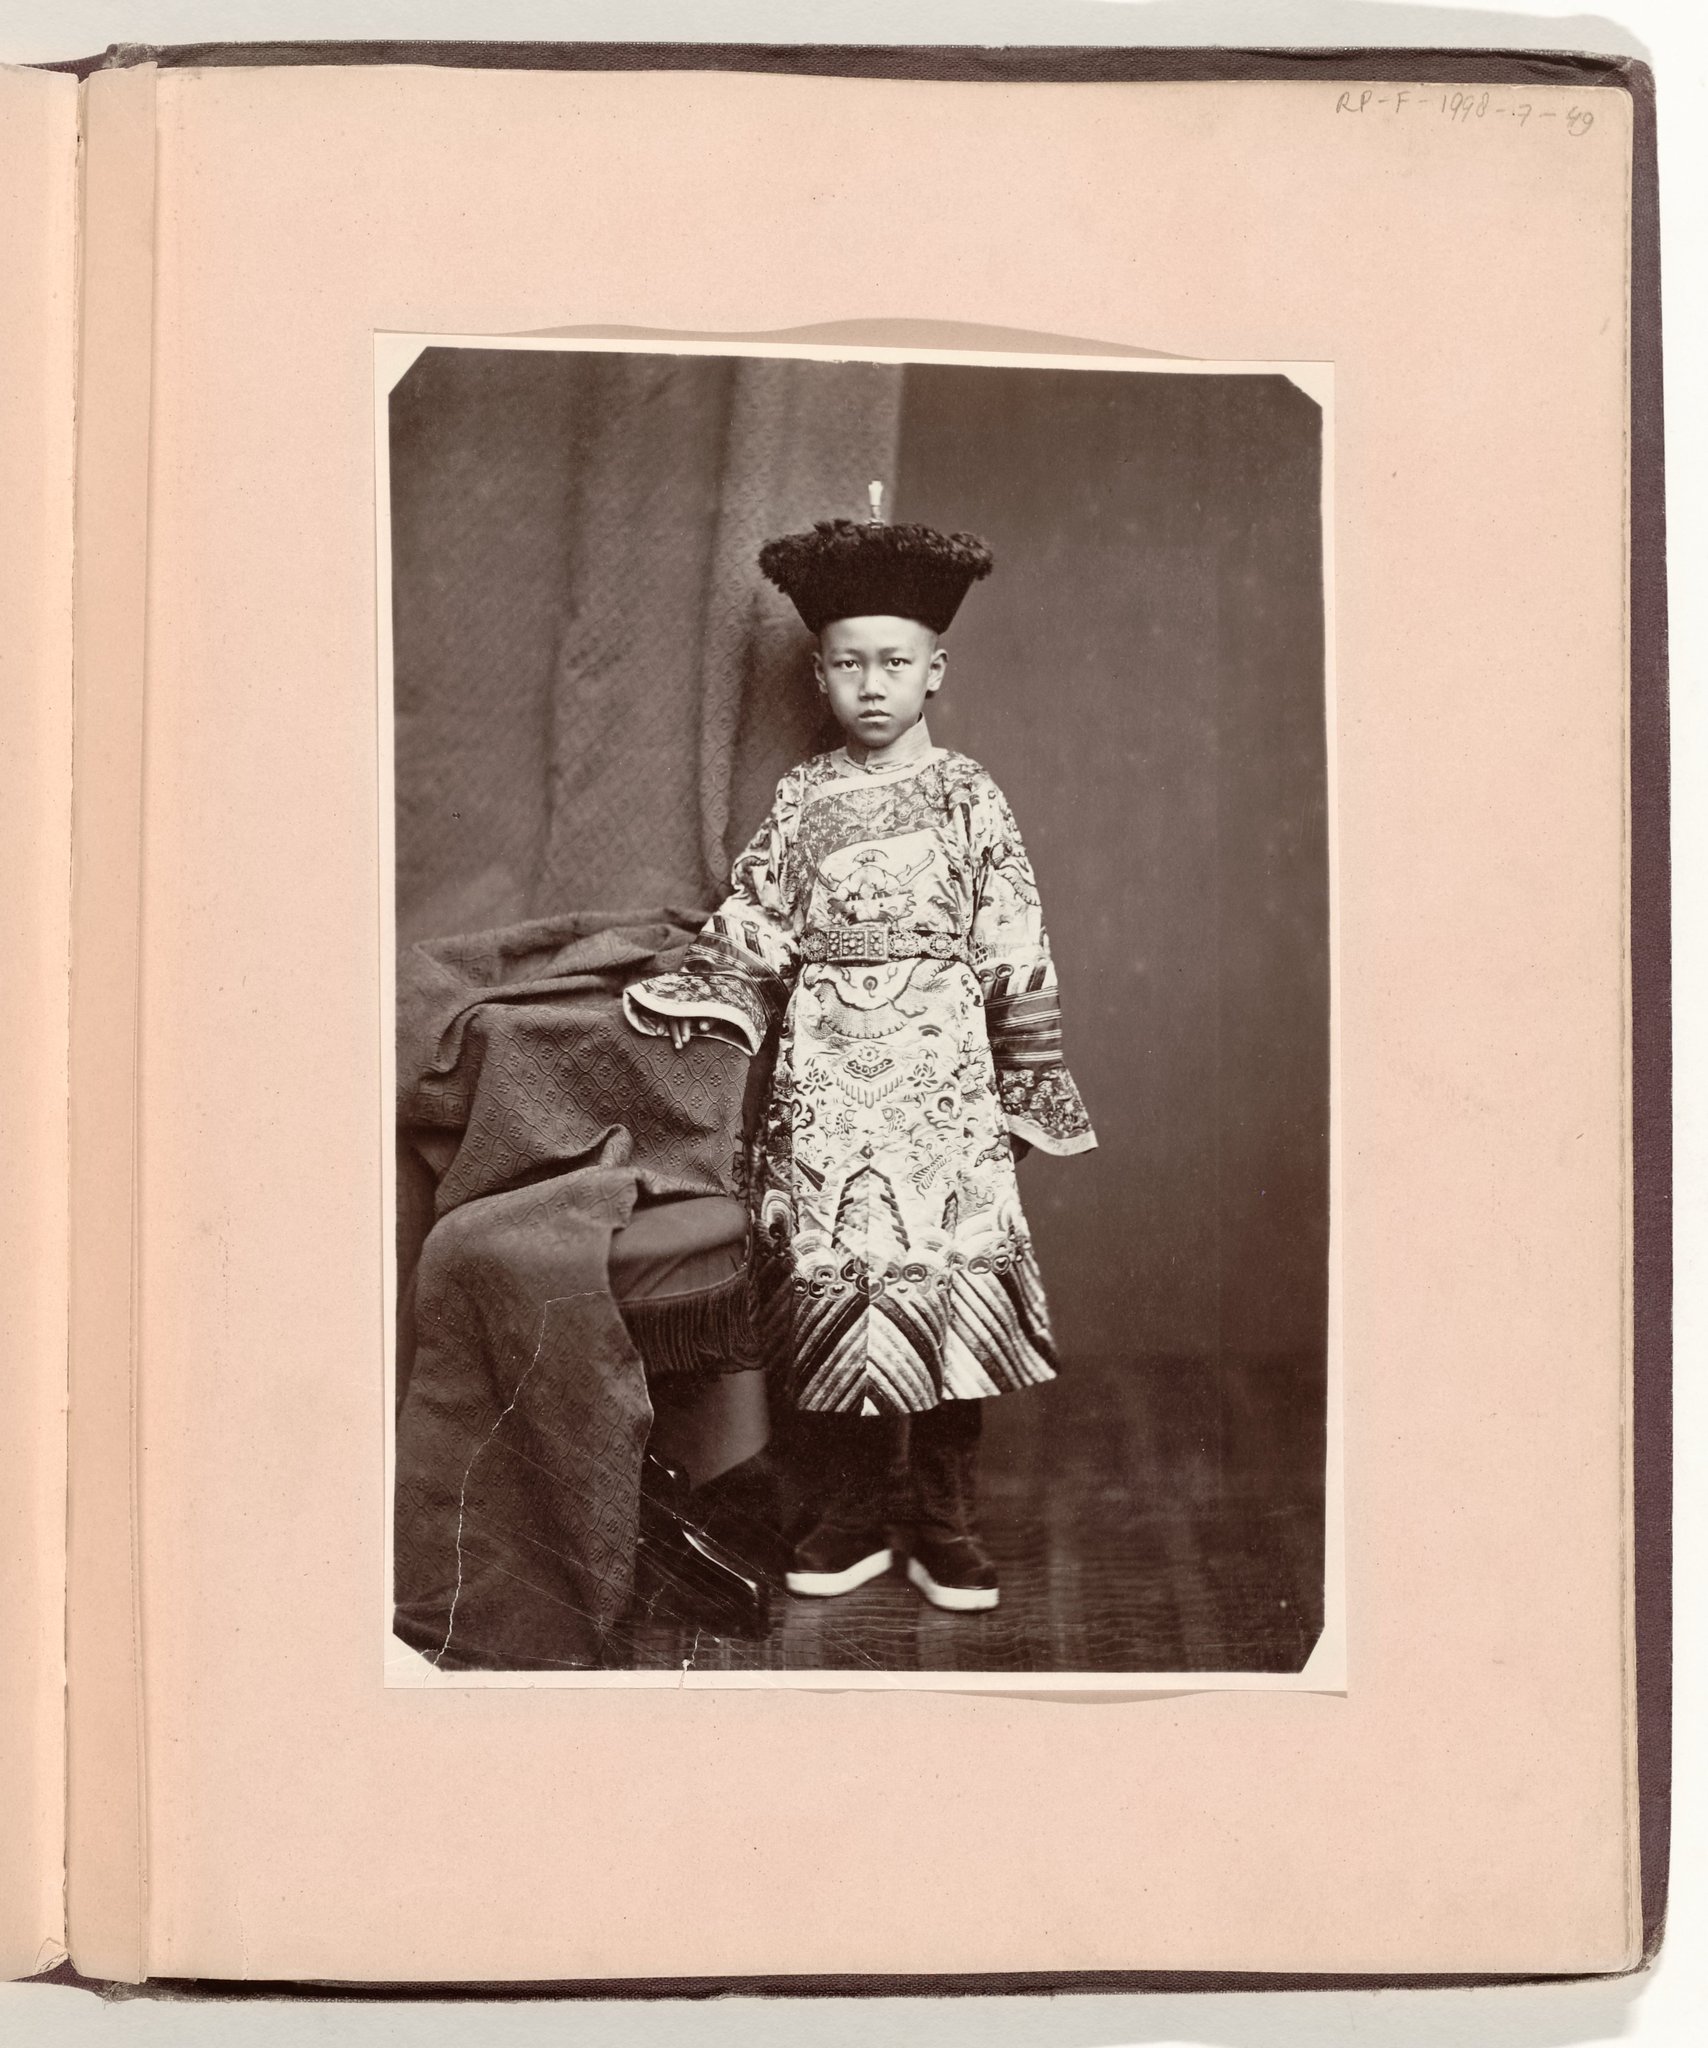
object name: album leaf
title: Portret van een onbekende Chinese jongen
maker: c. dietrich (fotograaf)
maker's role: fotograaf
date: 1875-1890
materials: cardboard, paper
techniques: albumen print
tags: boy (child between toddler and youth), anonymous historical person portrayed alone